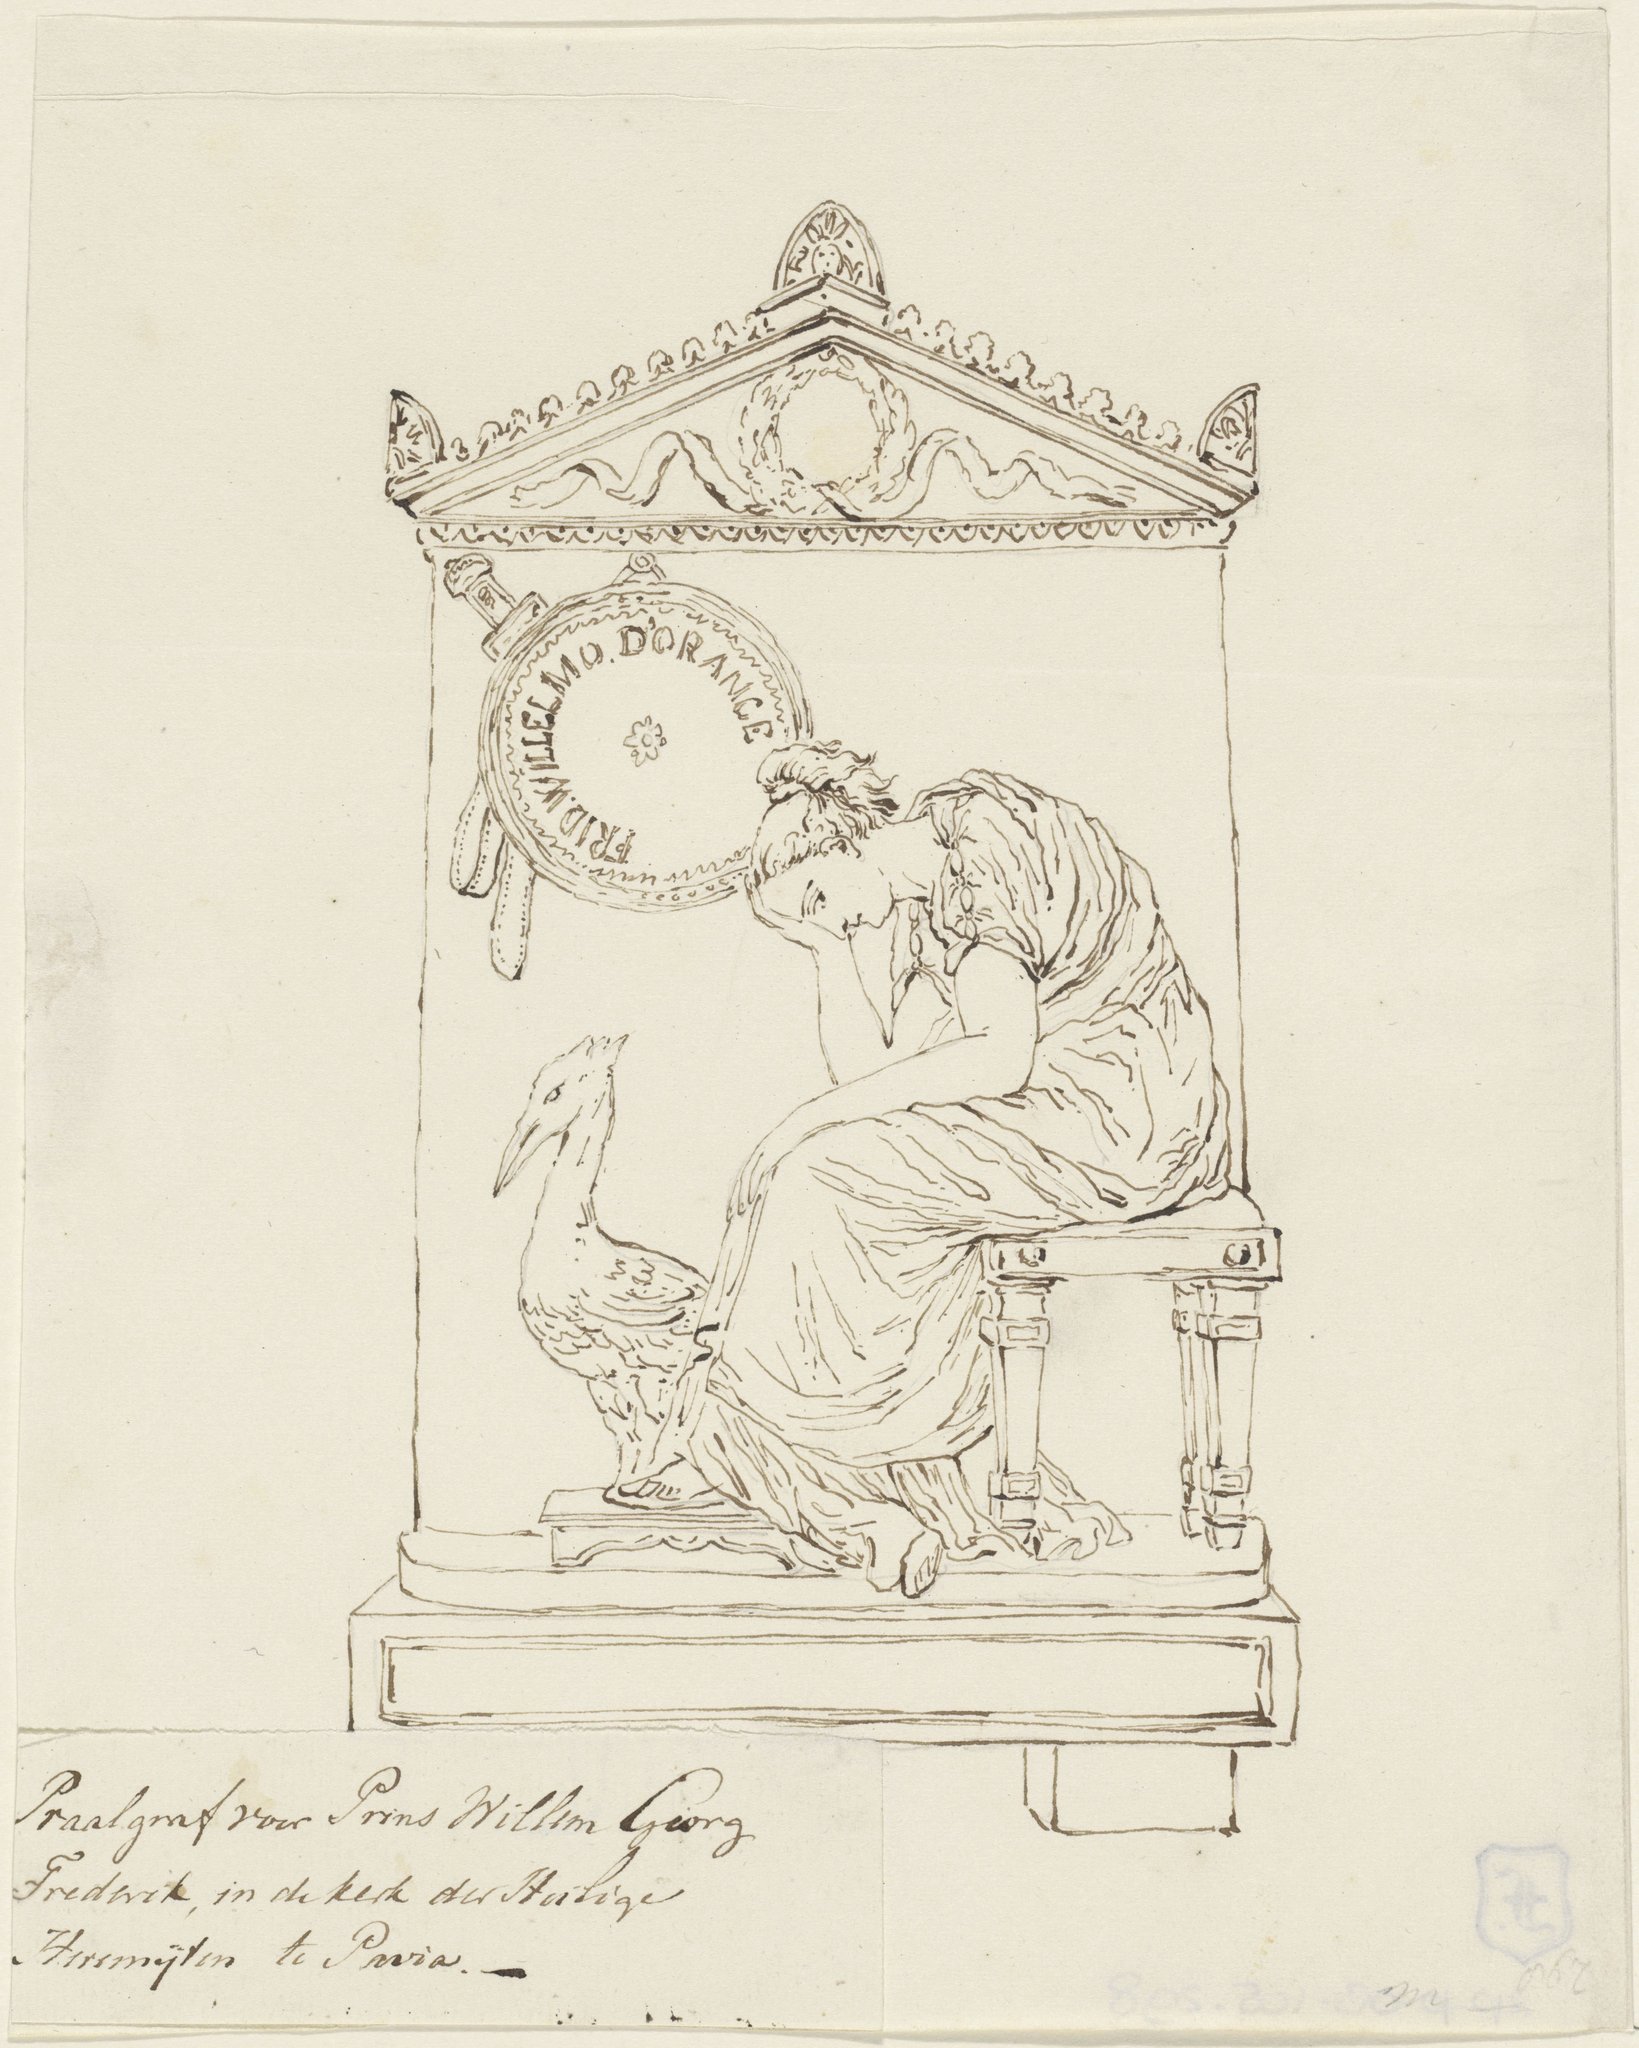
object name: drawing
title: Grafmonument voor Frederik, prins van Oranje-Nassau, 1799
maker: Anonymous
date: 1807-1871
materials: ink, paper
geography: low countries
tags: the hague, willem george frederik (prins van oranje-nassau), shore-birds and wading-birds: stork, grave-building, monumental tomb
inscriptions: collector's mark: Lugt 963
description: Grafmonument voor Frederik door Antonio Canova in de kruisgang van het Heremietenklooster te Padua, overleden op 6 januari 1799. Een treurende vrouw zit naast een ooievaar. Aan de muur een zwaard en een schild met randschrift. In de ondermarge drie regels Nederlandse tekst.